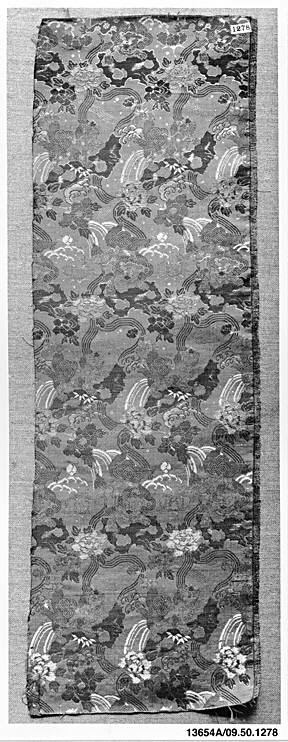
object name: piece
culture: japanese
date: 1801-1900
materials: silk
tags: leaves